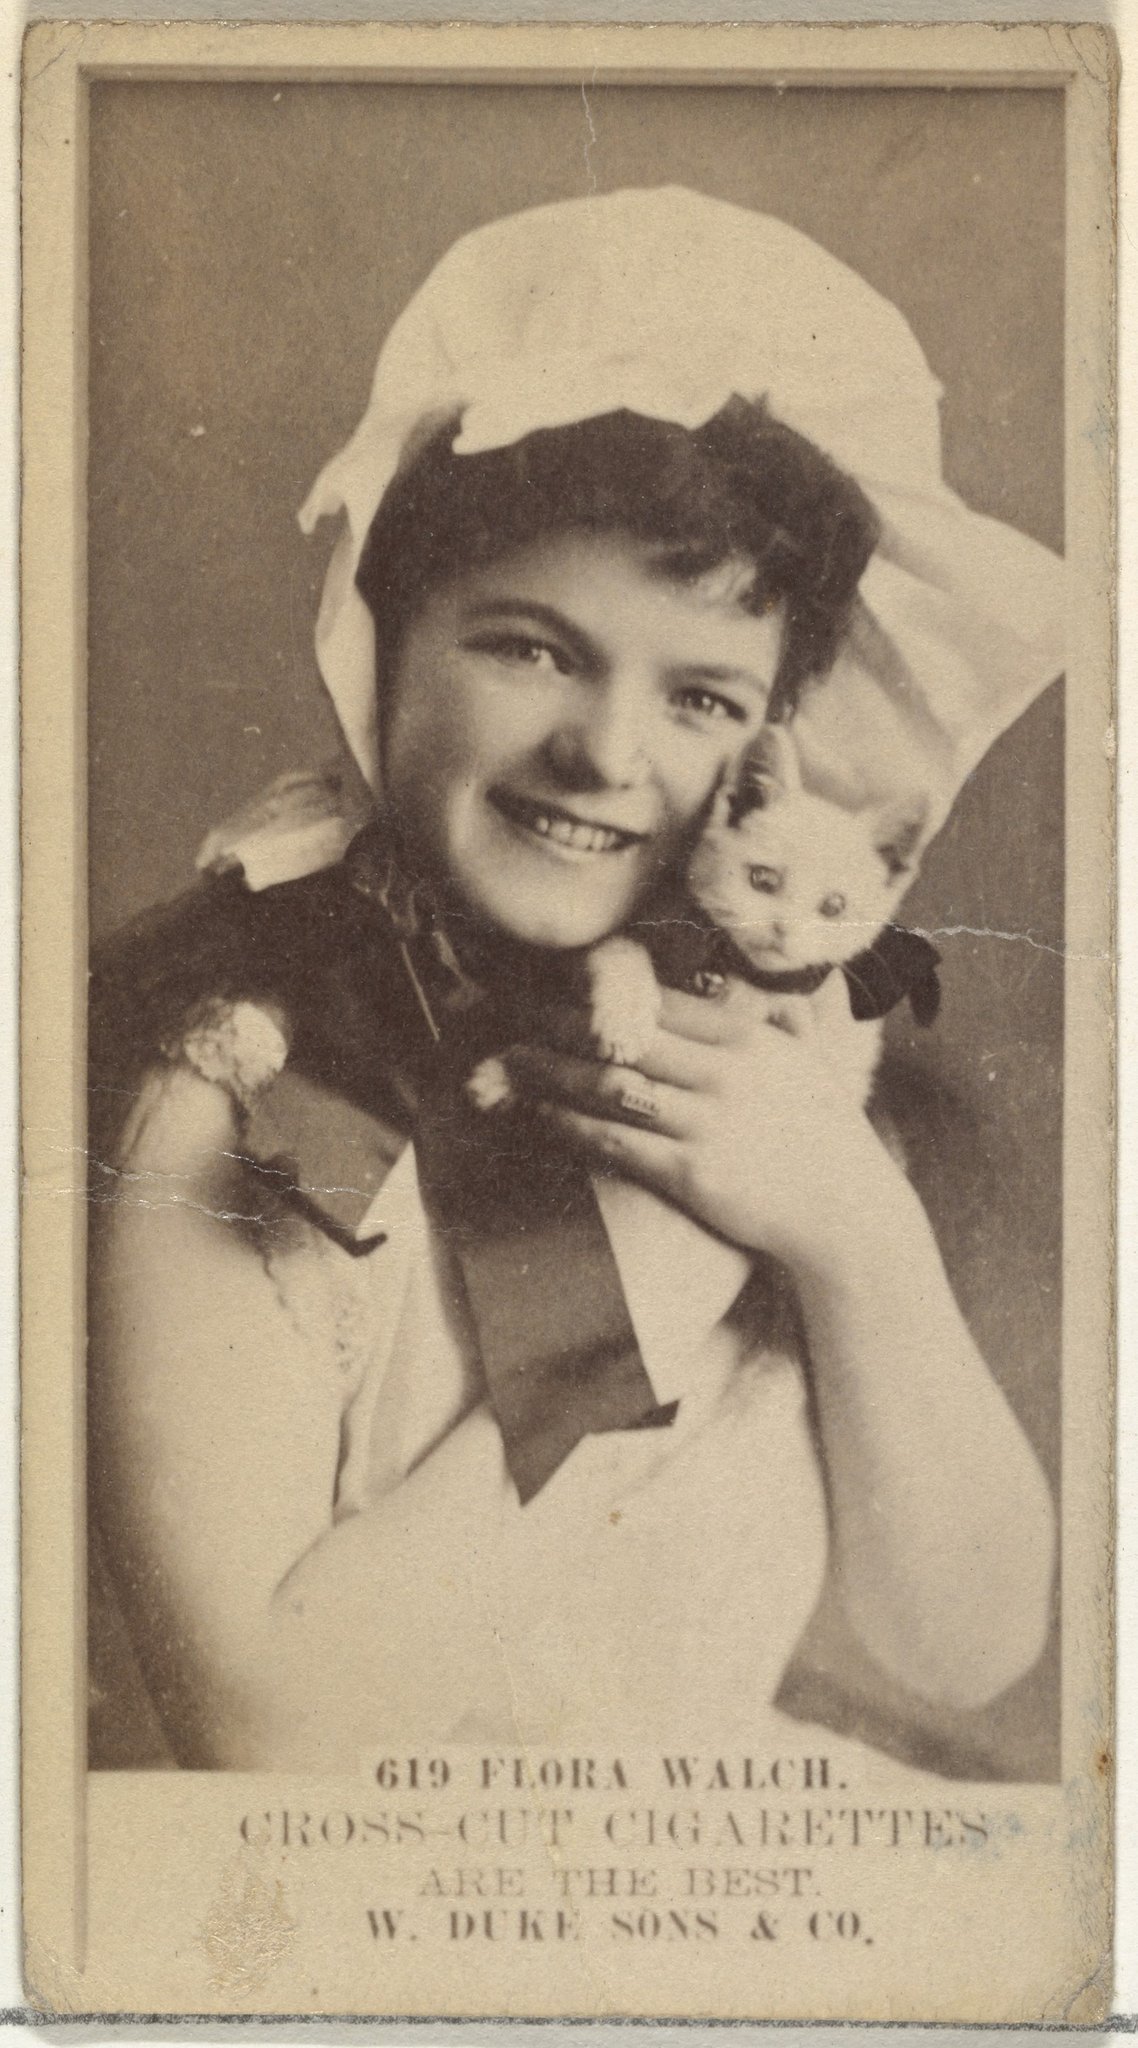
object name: photograph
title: Card Number 619, Flora Walch, from the Actors and Actresses series (N145-3) issued by Duke Sons & Co. to promote Cross Cut Cigarettes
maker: w. duke, sons & co.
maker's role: publisher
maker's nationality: american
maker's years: 1870-1920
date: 1880-1889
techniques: albumen silver print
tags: portraits,women,cats,actresses